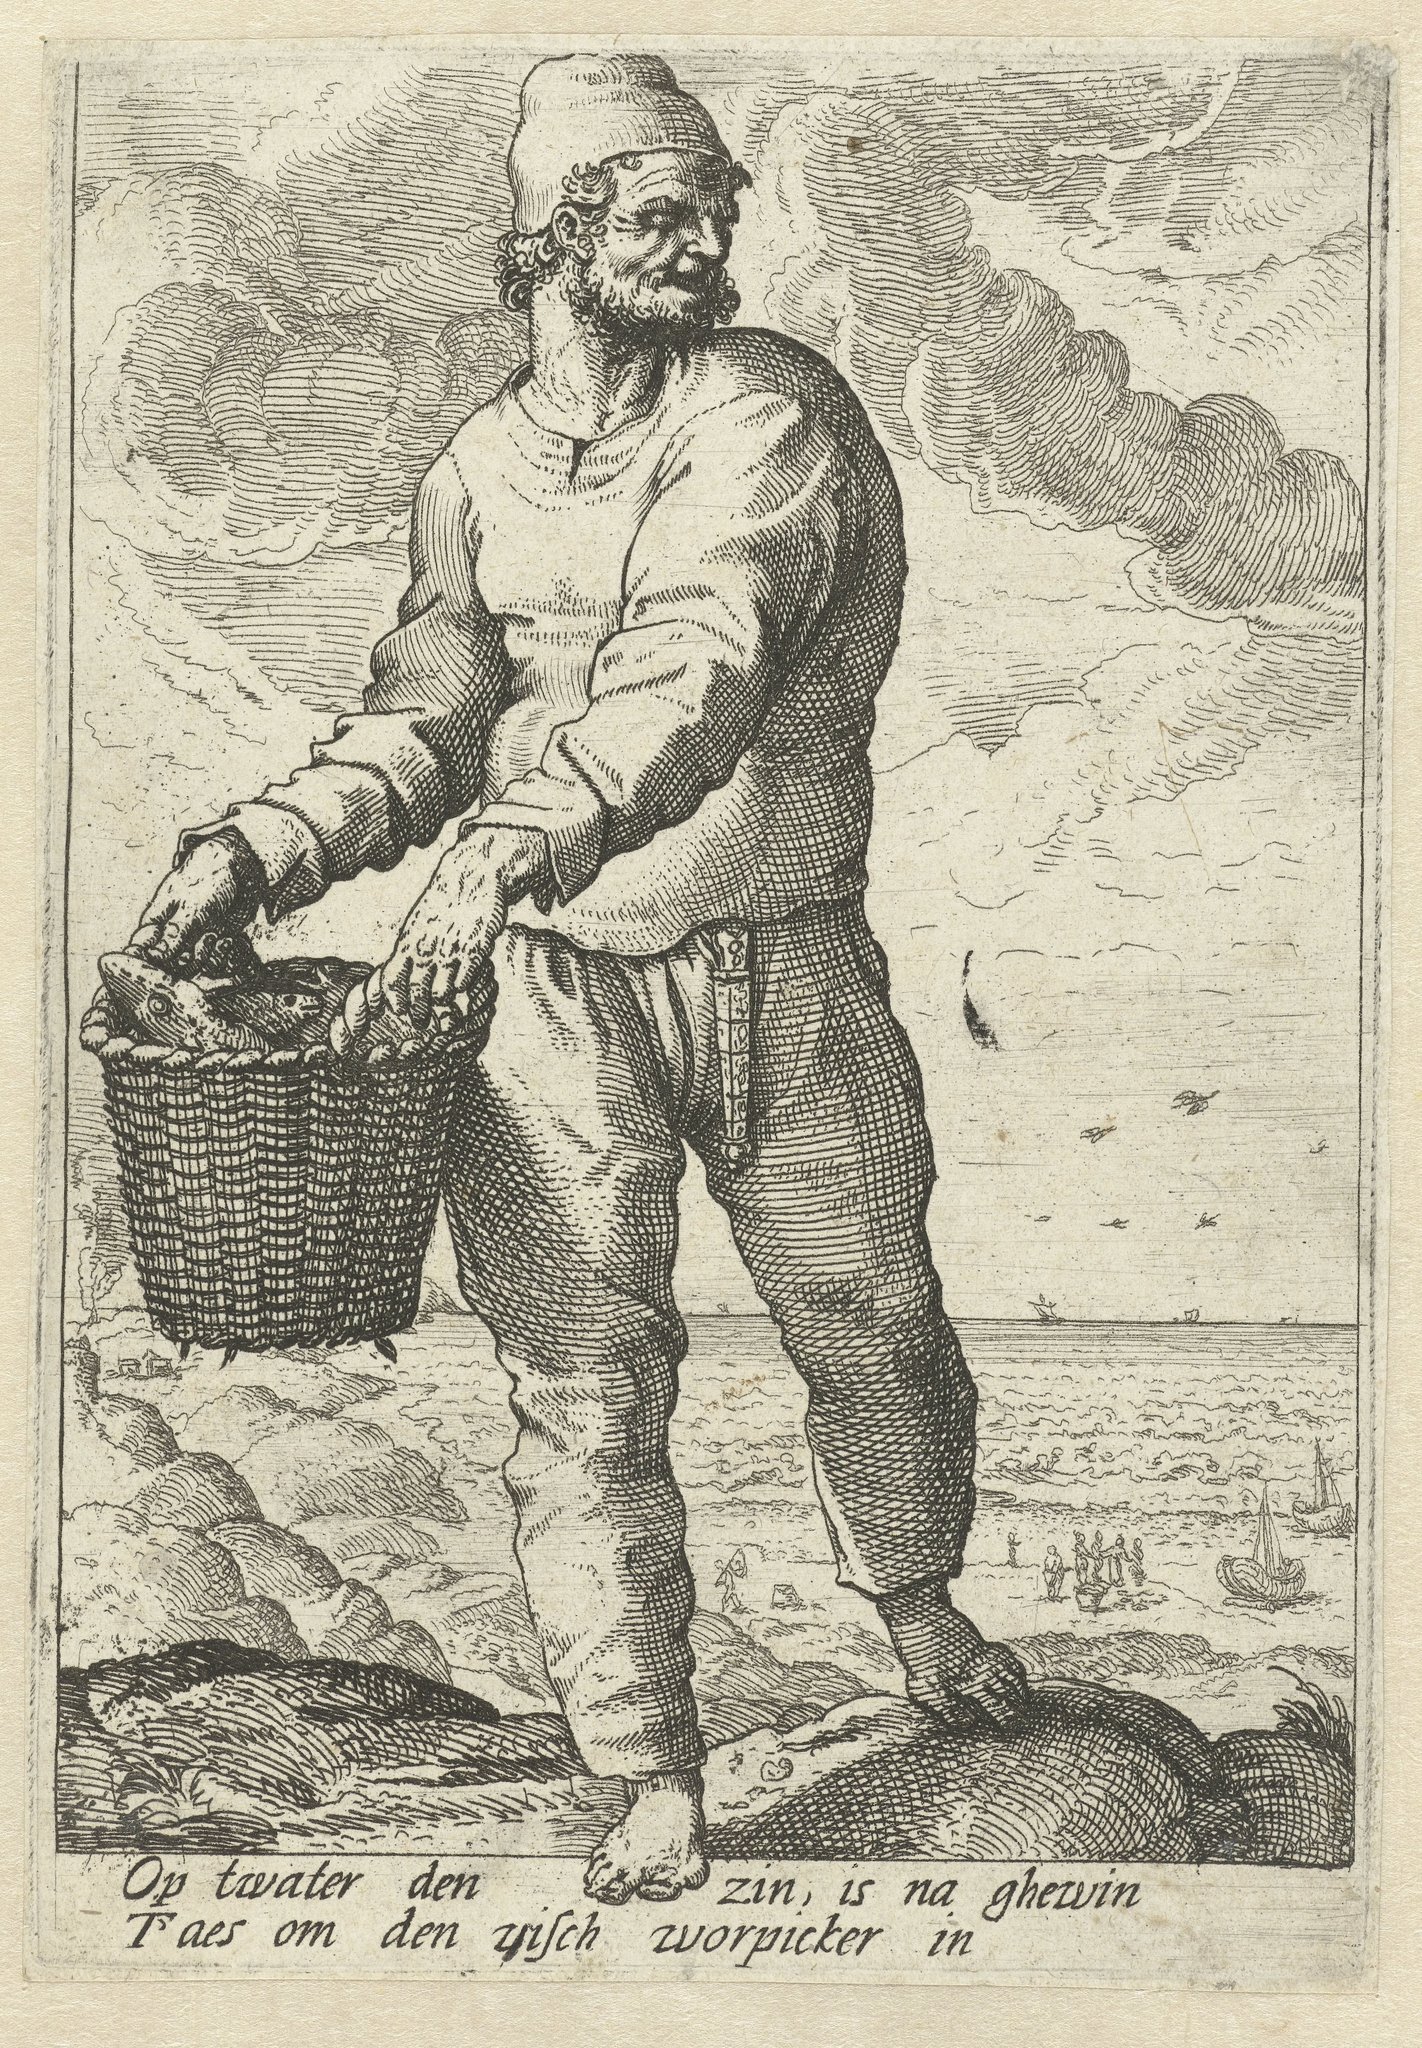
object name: print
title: De vier elementen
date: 1590-1600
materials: paper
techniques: engraving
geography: cologne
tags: water (one of the four elements)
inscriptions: collector's mark: Lugt 240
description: Een visser met een mand vis aan een strand. Onder de voorstelling twee versregels in het Nederlands. Deze prent is onderdeel van een serie prenten van de vier elementen.